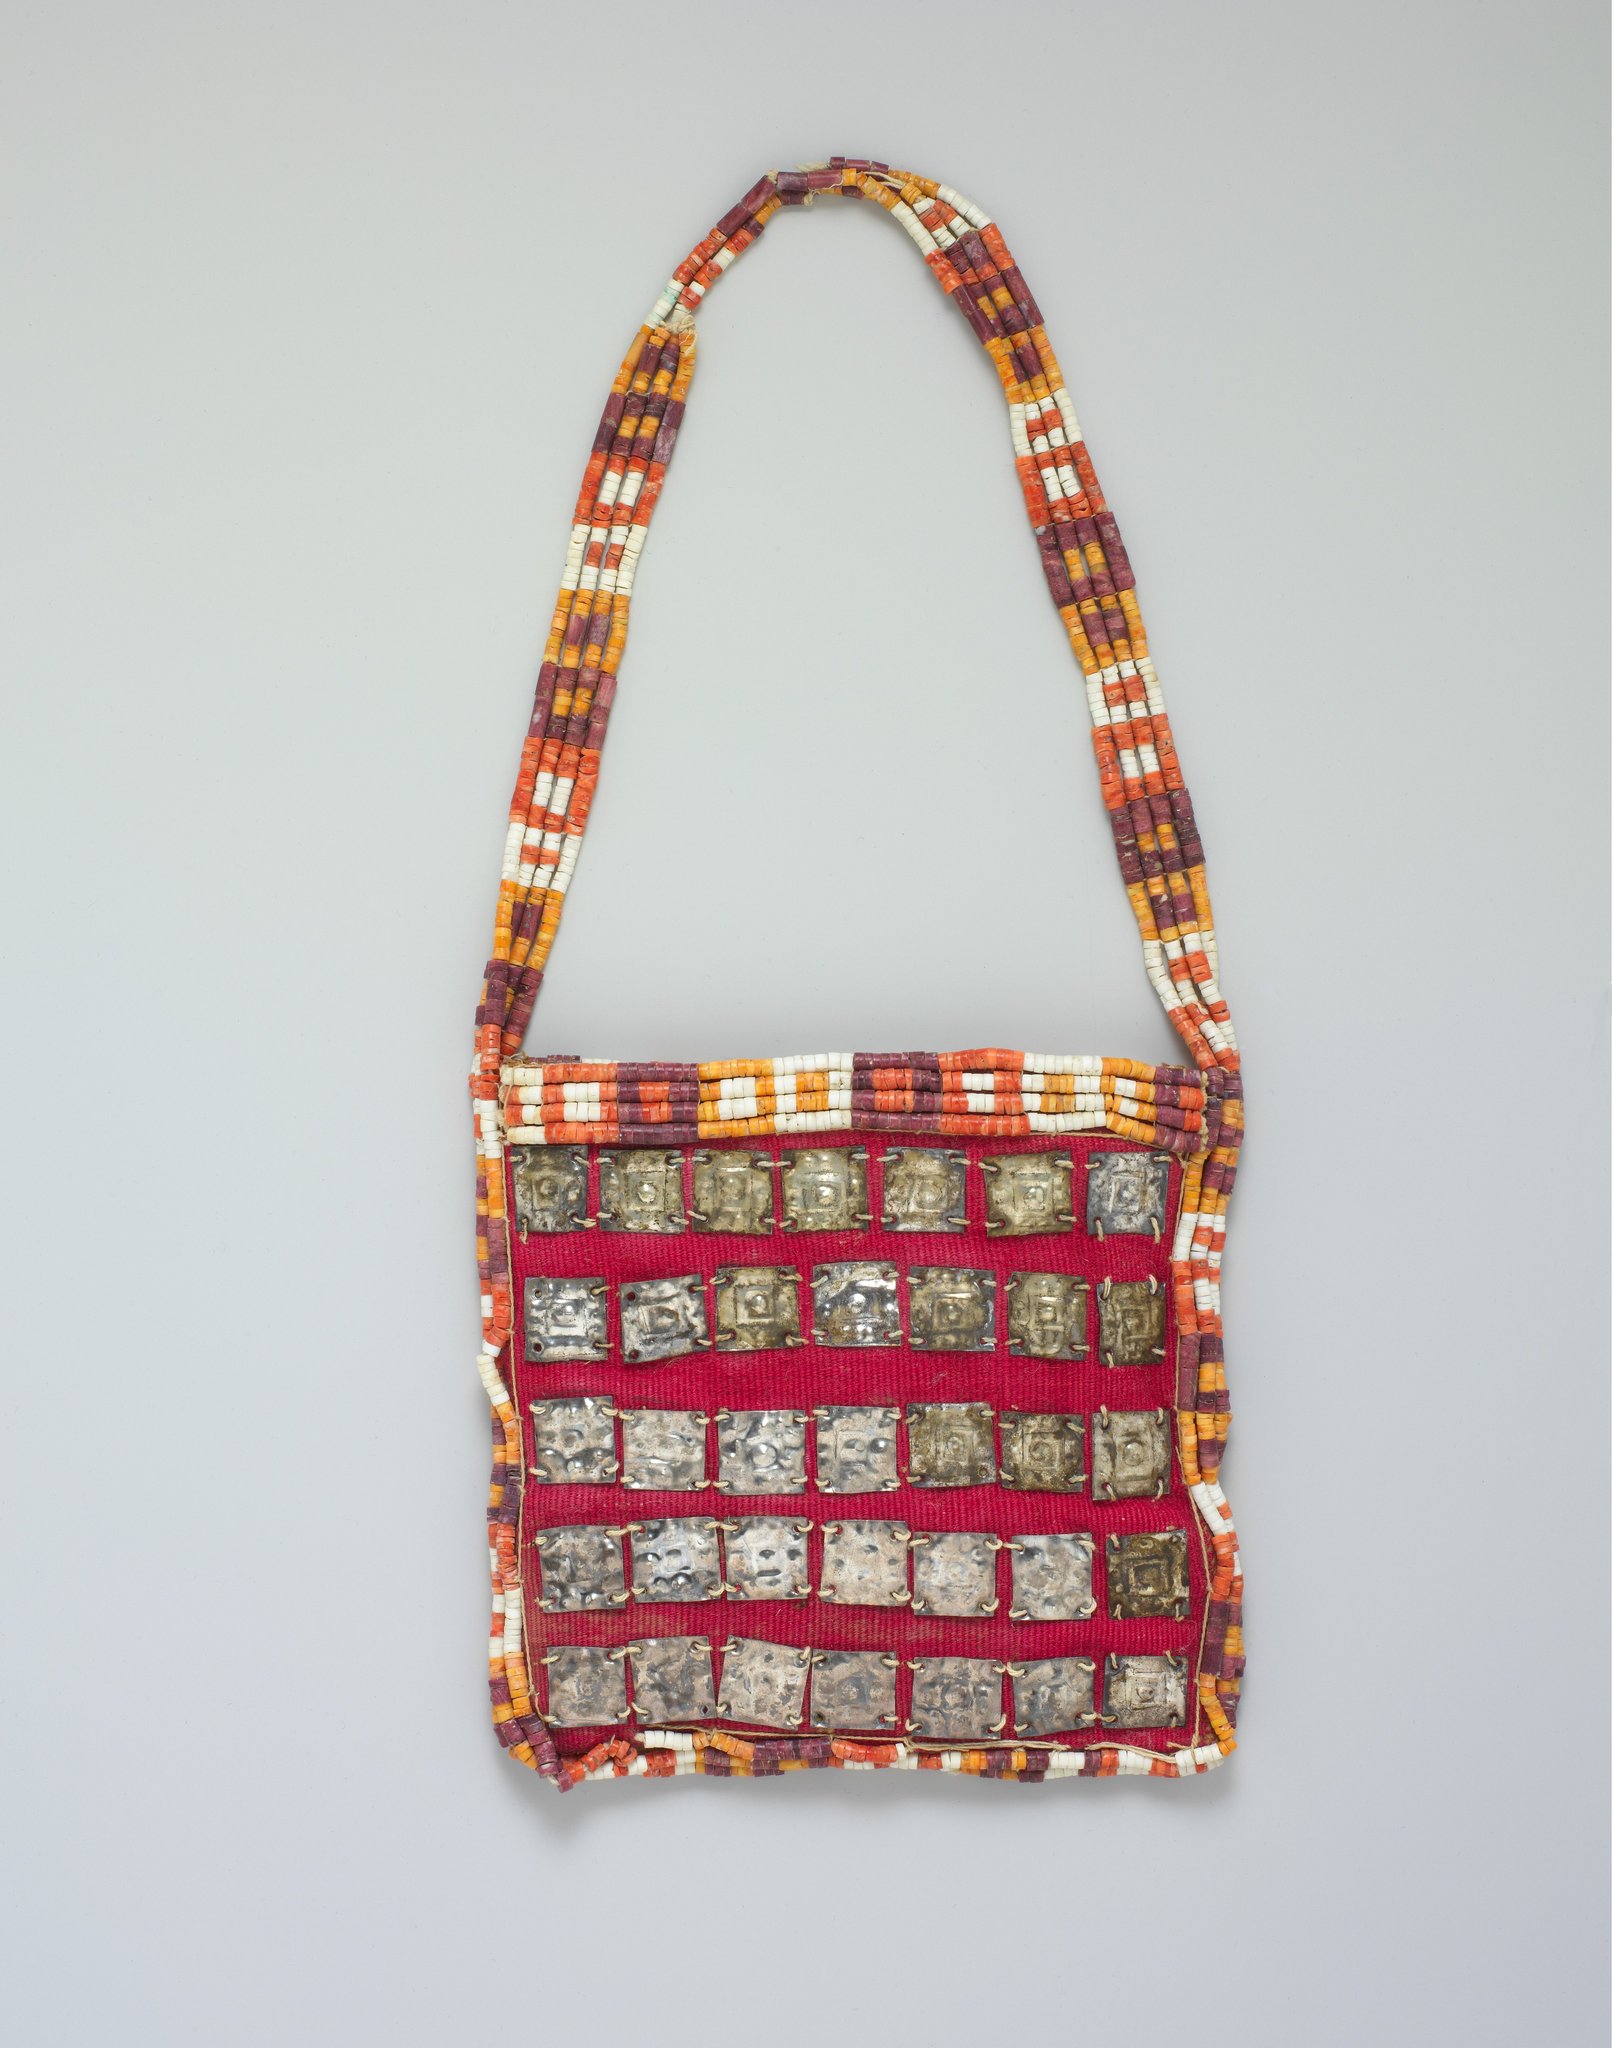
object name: bag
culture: chimú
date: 1301-1500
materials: animal fiber, cotton, shell, silver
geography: peru